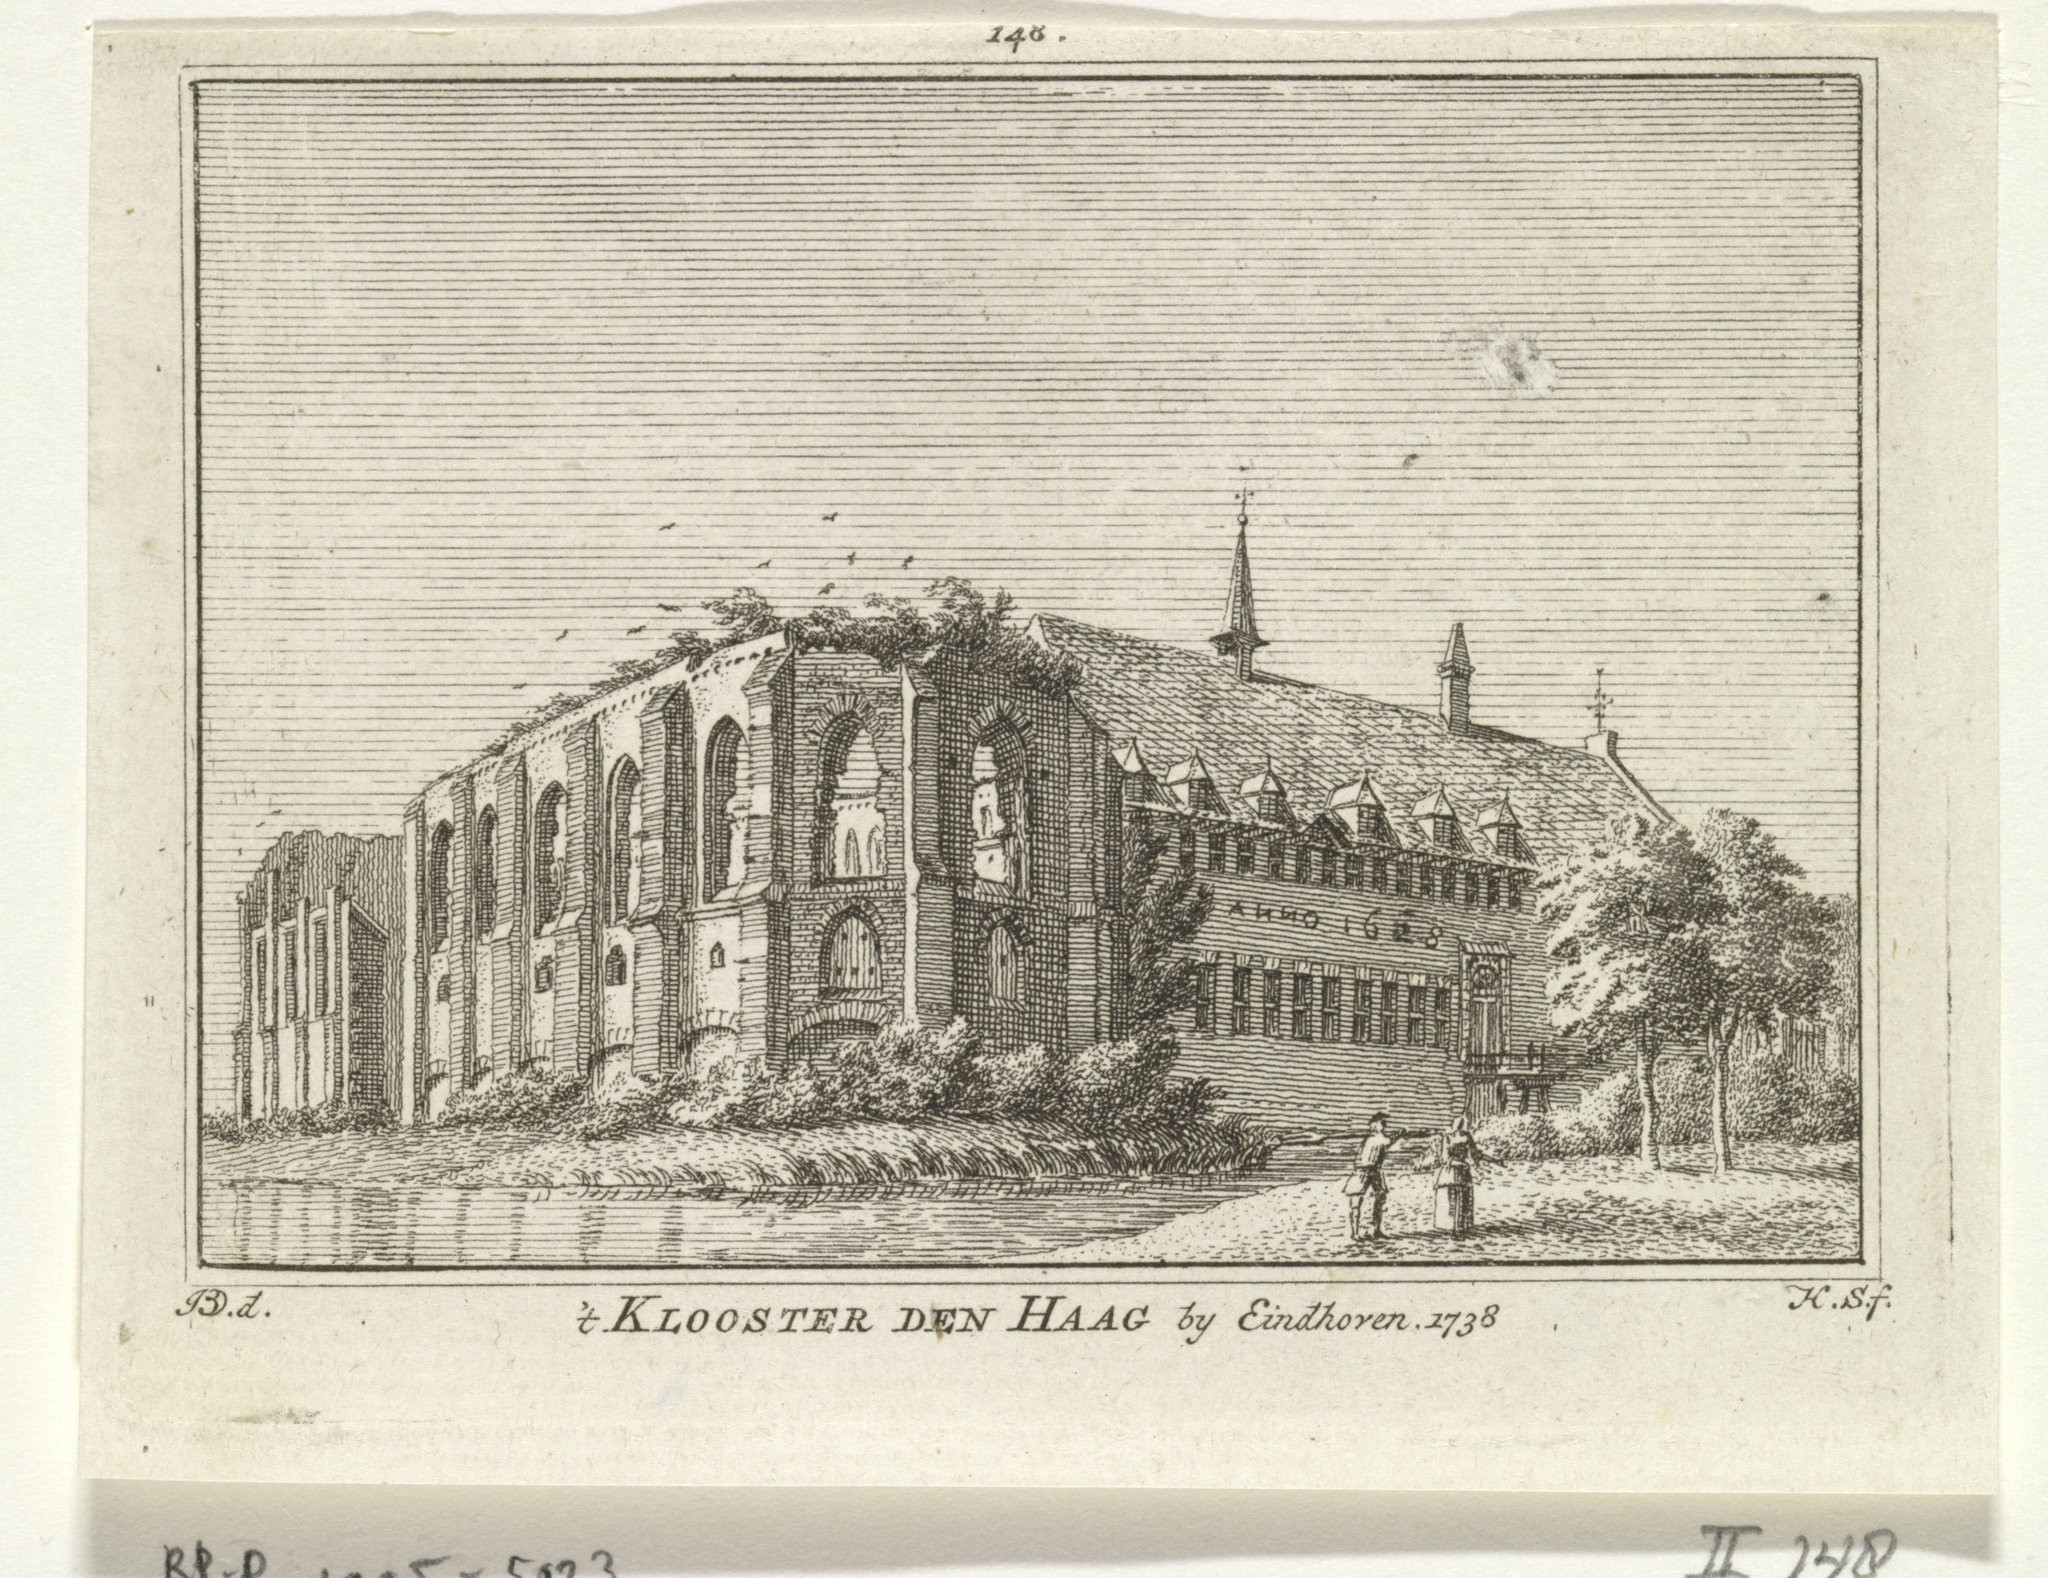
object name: print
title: Gezicht op klooster ten Hage, Eindhoven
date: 1746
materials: paper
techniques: etching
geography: haarlem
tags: ruin of church, monastery, etc.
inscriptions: collector's mark: Lugt 2228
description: Prent gebruikt in: Het verheerlykt Nederland of kabinet van hedendaagsche gezigten van steden, dorpen, sloten ... en andere voornaame stad- en landgebouwen, in en omtrent alle de byzondere Vereenigde Nederlandsche Provinciën : gedurende de laatste jaaren door vermaarden kunsttekenaren na het leven getekent en ... in 't koper gebragt ... dienende tot opheldering der beschryvinge van den Tegenwoordigen Staat der Vereenigde Nederlanden. Deel II, 1746. Amsterdam: Isaac Tirion, 1745-1774.